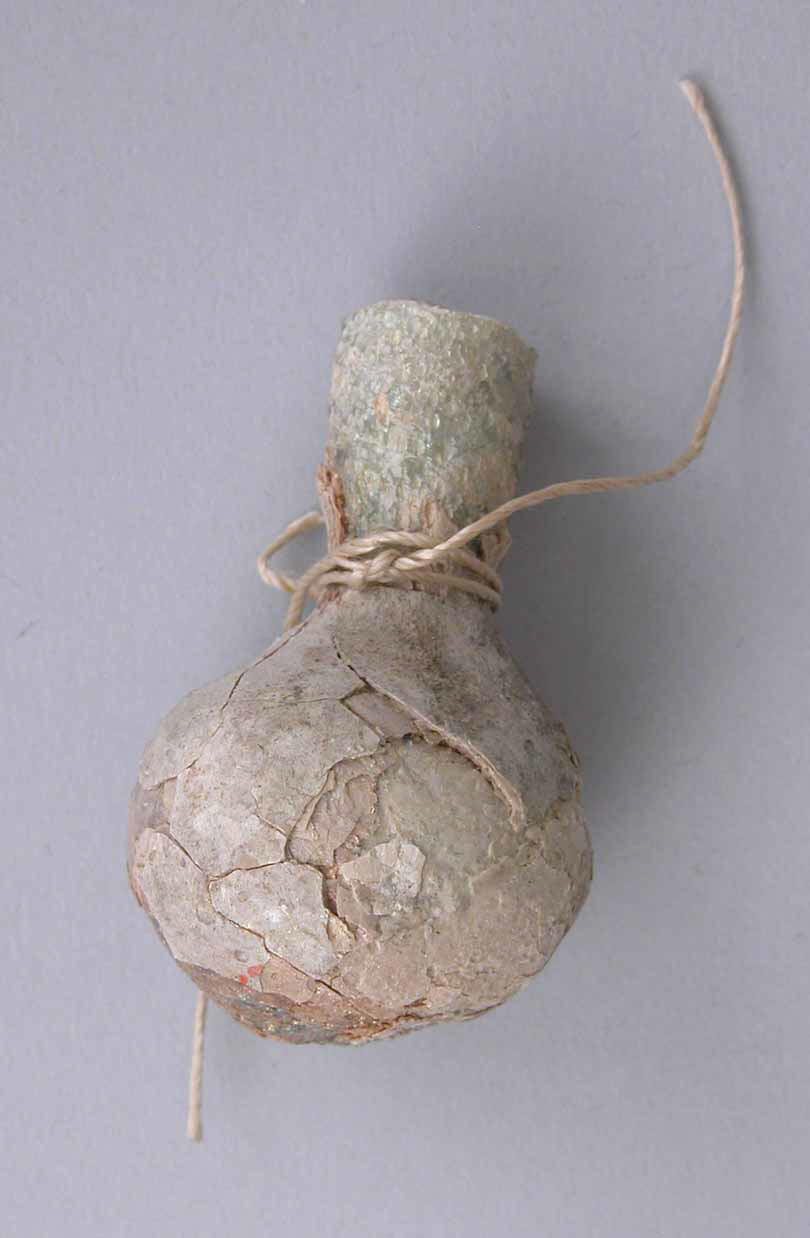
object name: bottle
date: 601-800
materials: glass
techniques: glassblowing, tooling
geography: iraq